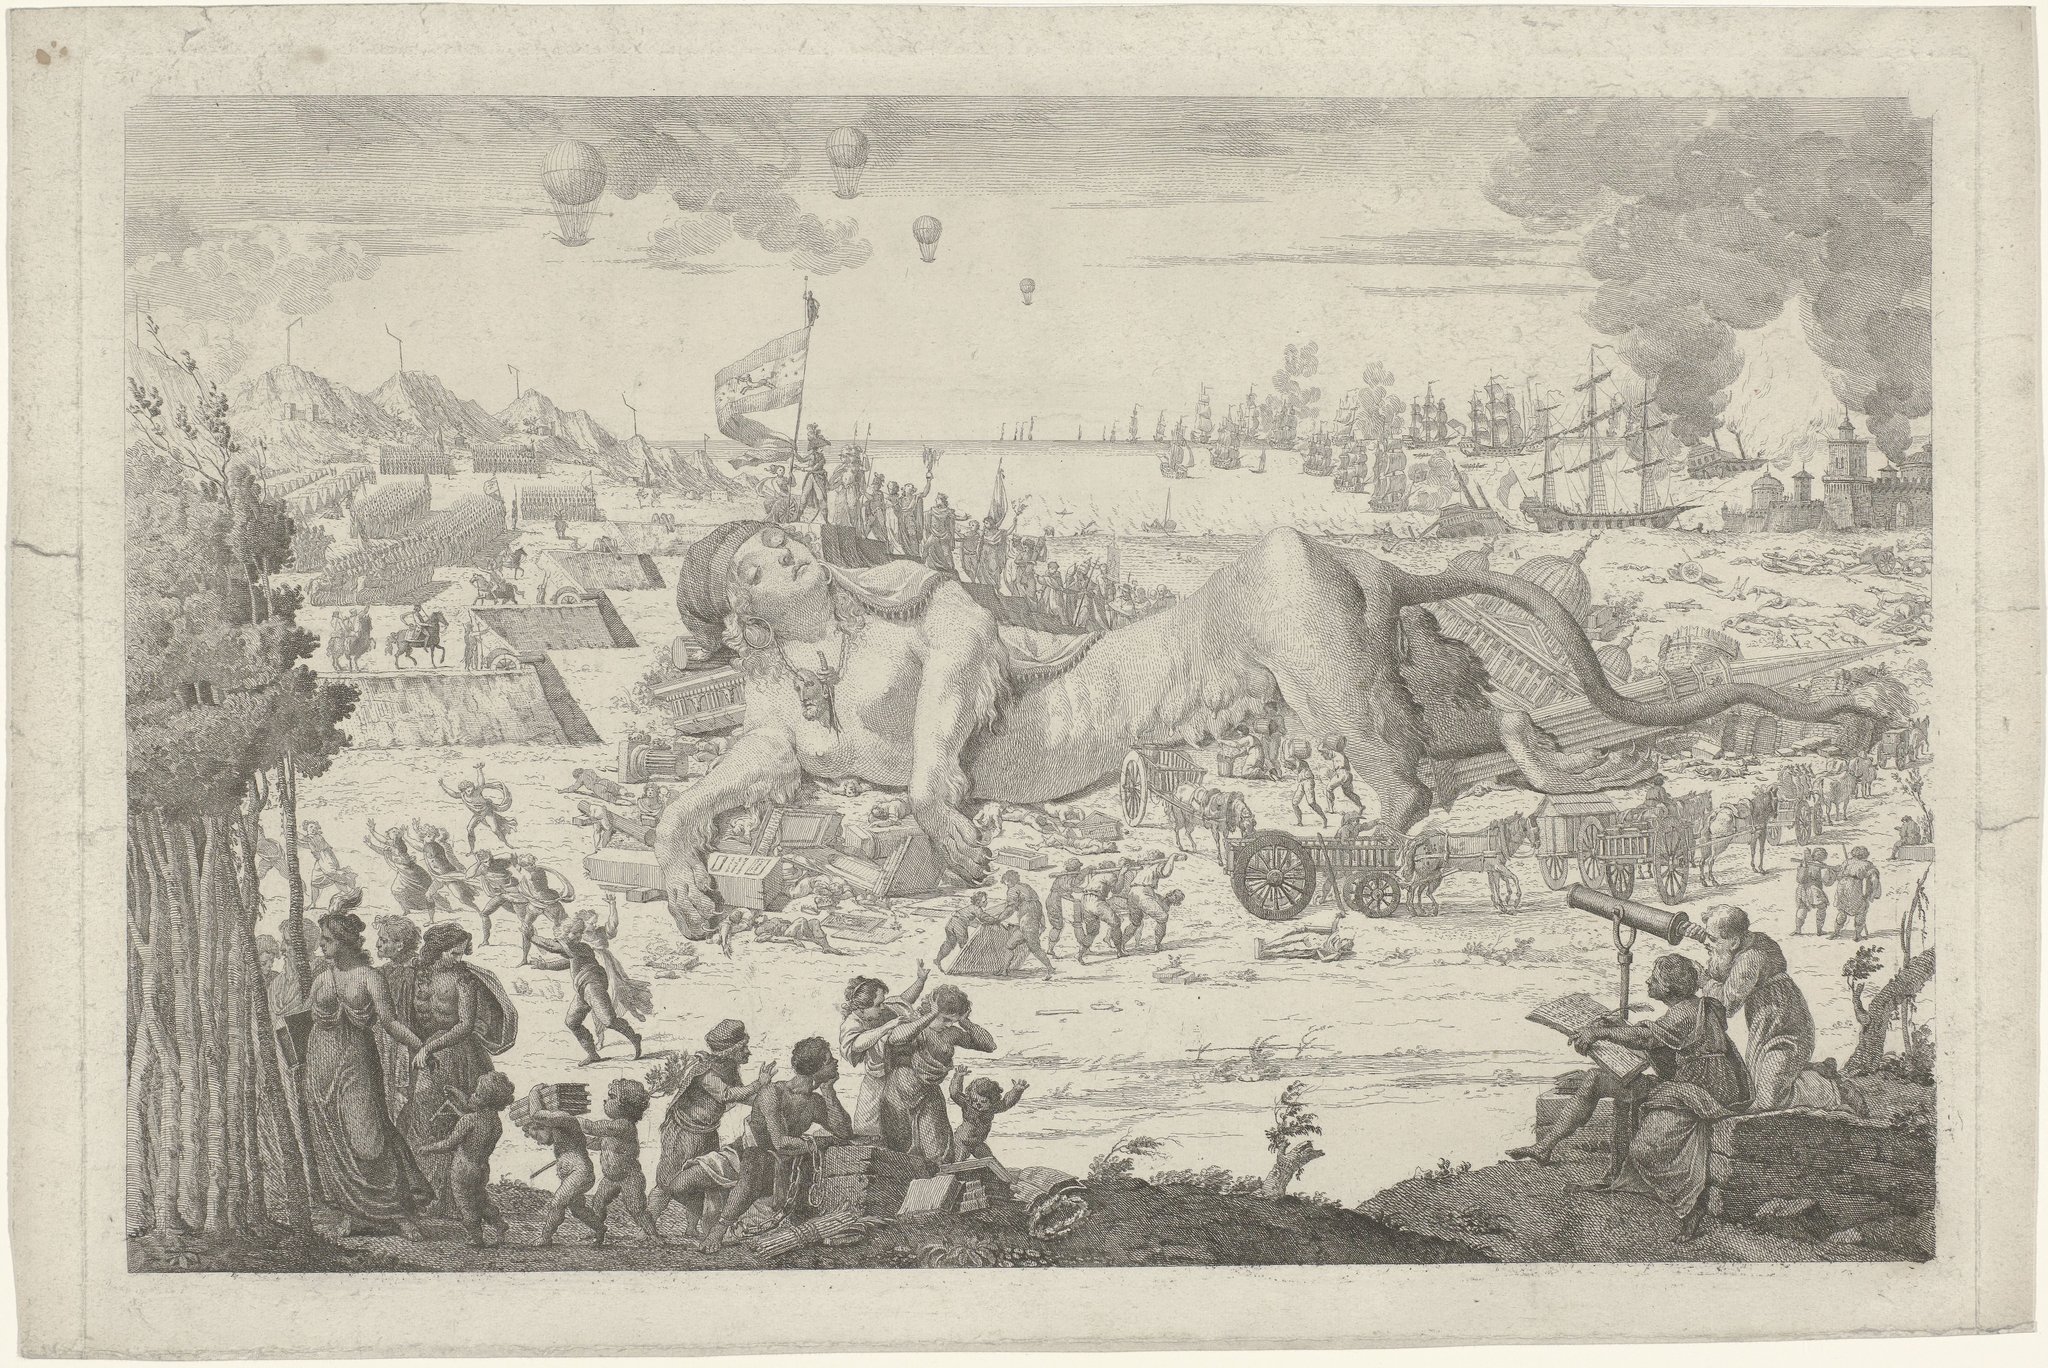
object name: print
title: De slapende sfinx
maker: Anonymous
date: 1796-1797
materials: paper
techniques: engraving, etching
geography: italy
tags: napoleon i (emperor of the french), sphinx (lion/woman); 'sfinge' (ripa) - aa - female human figure, art, the soldier; the soldier's life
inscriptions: collector's mark: Lugt 2760, collector's mark: Lugt 2228, inscription: ‘La grande effigge’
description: Een reusachtige sfinx ligt languit op ruïnes, mensen en gebouwen verpletterend. Links een veldtocht, rechts een zeeslag, achter de sfinx een optocht met Napoleon Bonaparte voorop. Op de voorgrond karren om beelden te transporteren. Een allegorie op de Franse veldtochten in Italië en de plundering van kunstschatten.